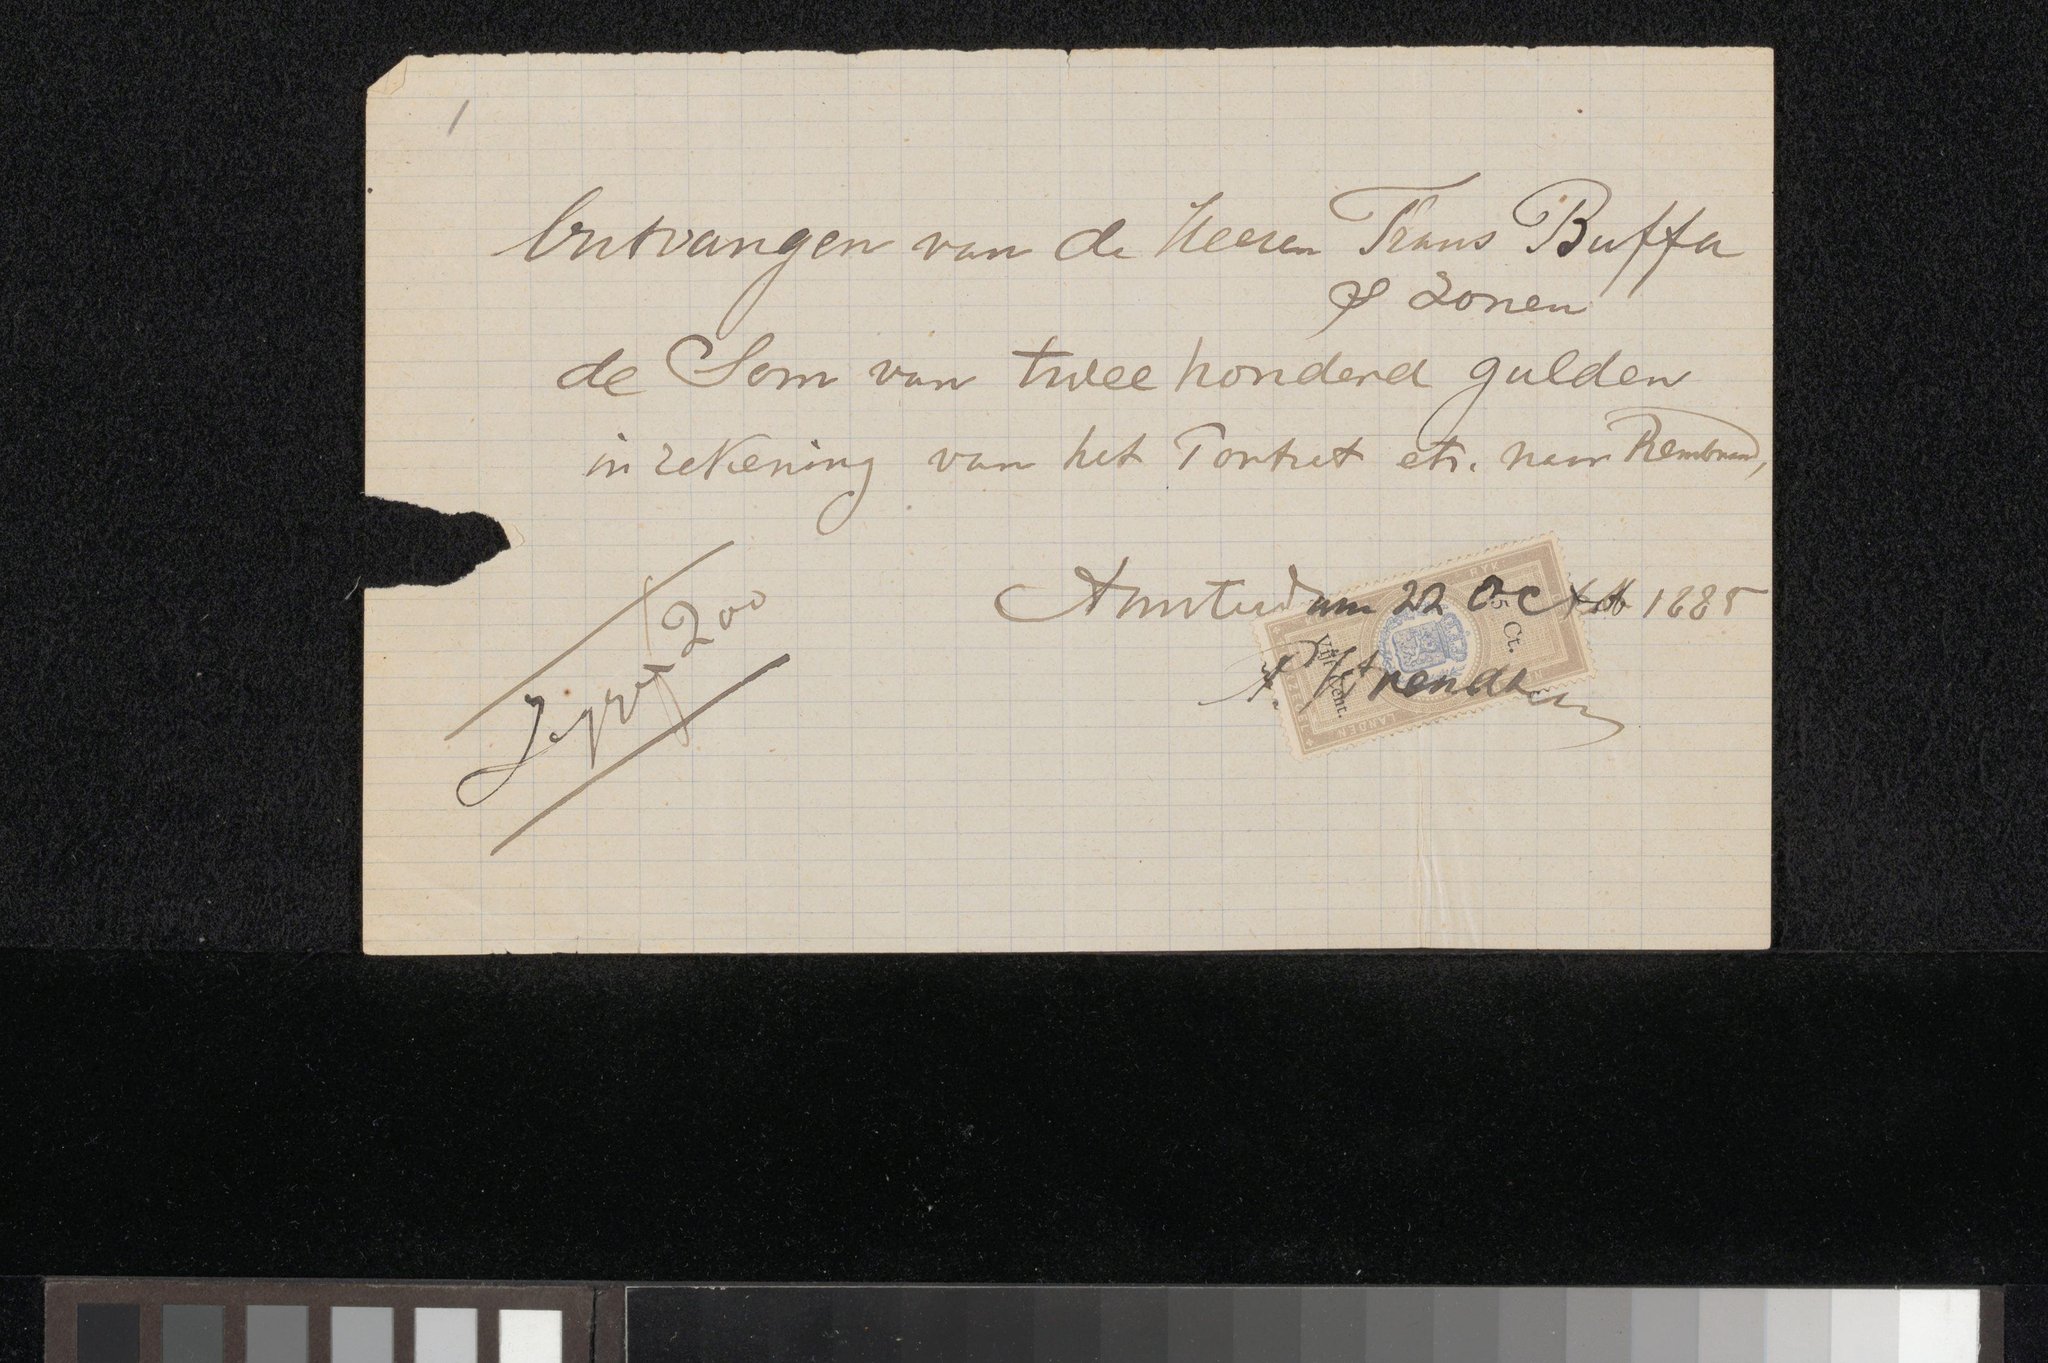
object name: ontvangstbewijs, kwitantie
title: Ontvangstbewijs aan Petrus Johannes Arendzen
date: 1885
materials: ink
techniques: pen, writing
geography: amsterdam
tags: leiden, painter, print maker, rembrandt van rijn, the graphic arts, historical persons (portraits and scenes from the life), money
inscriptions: collector's mark: Lugt 2233